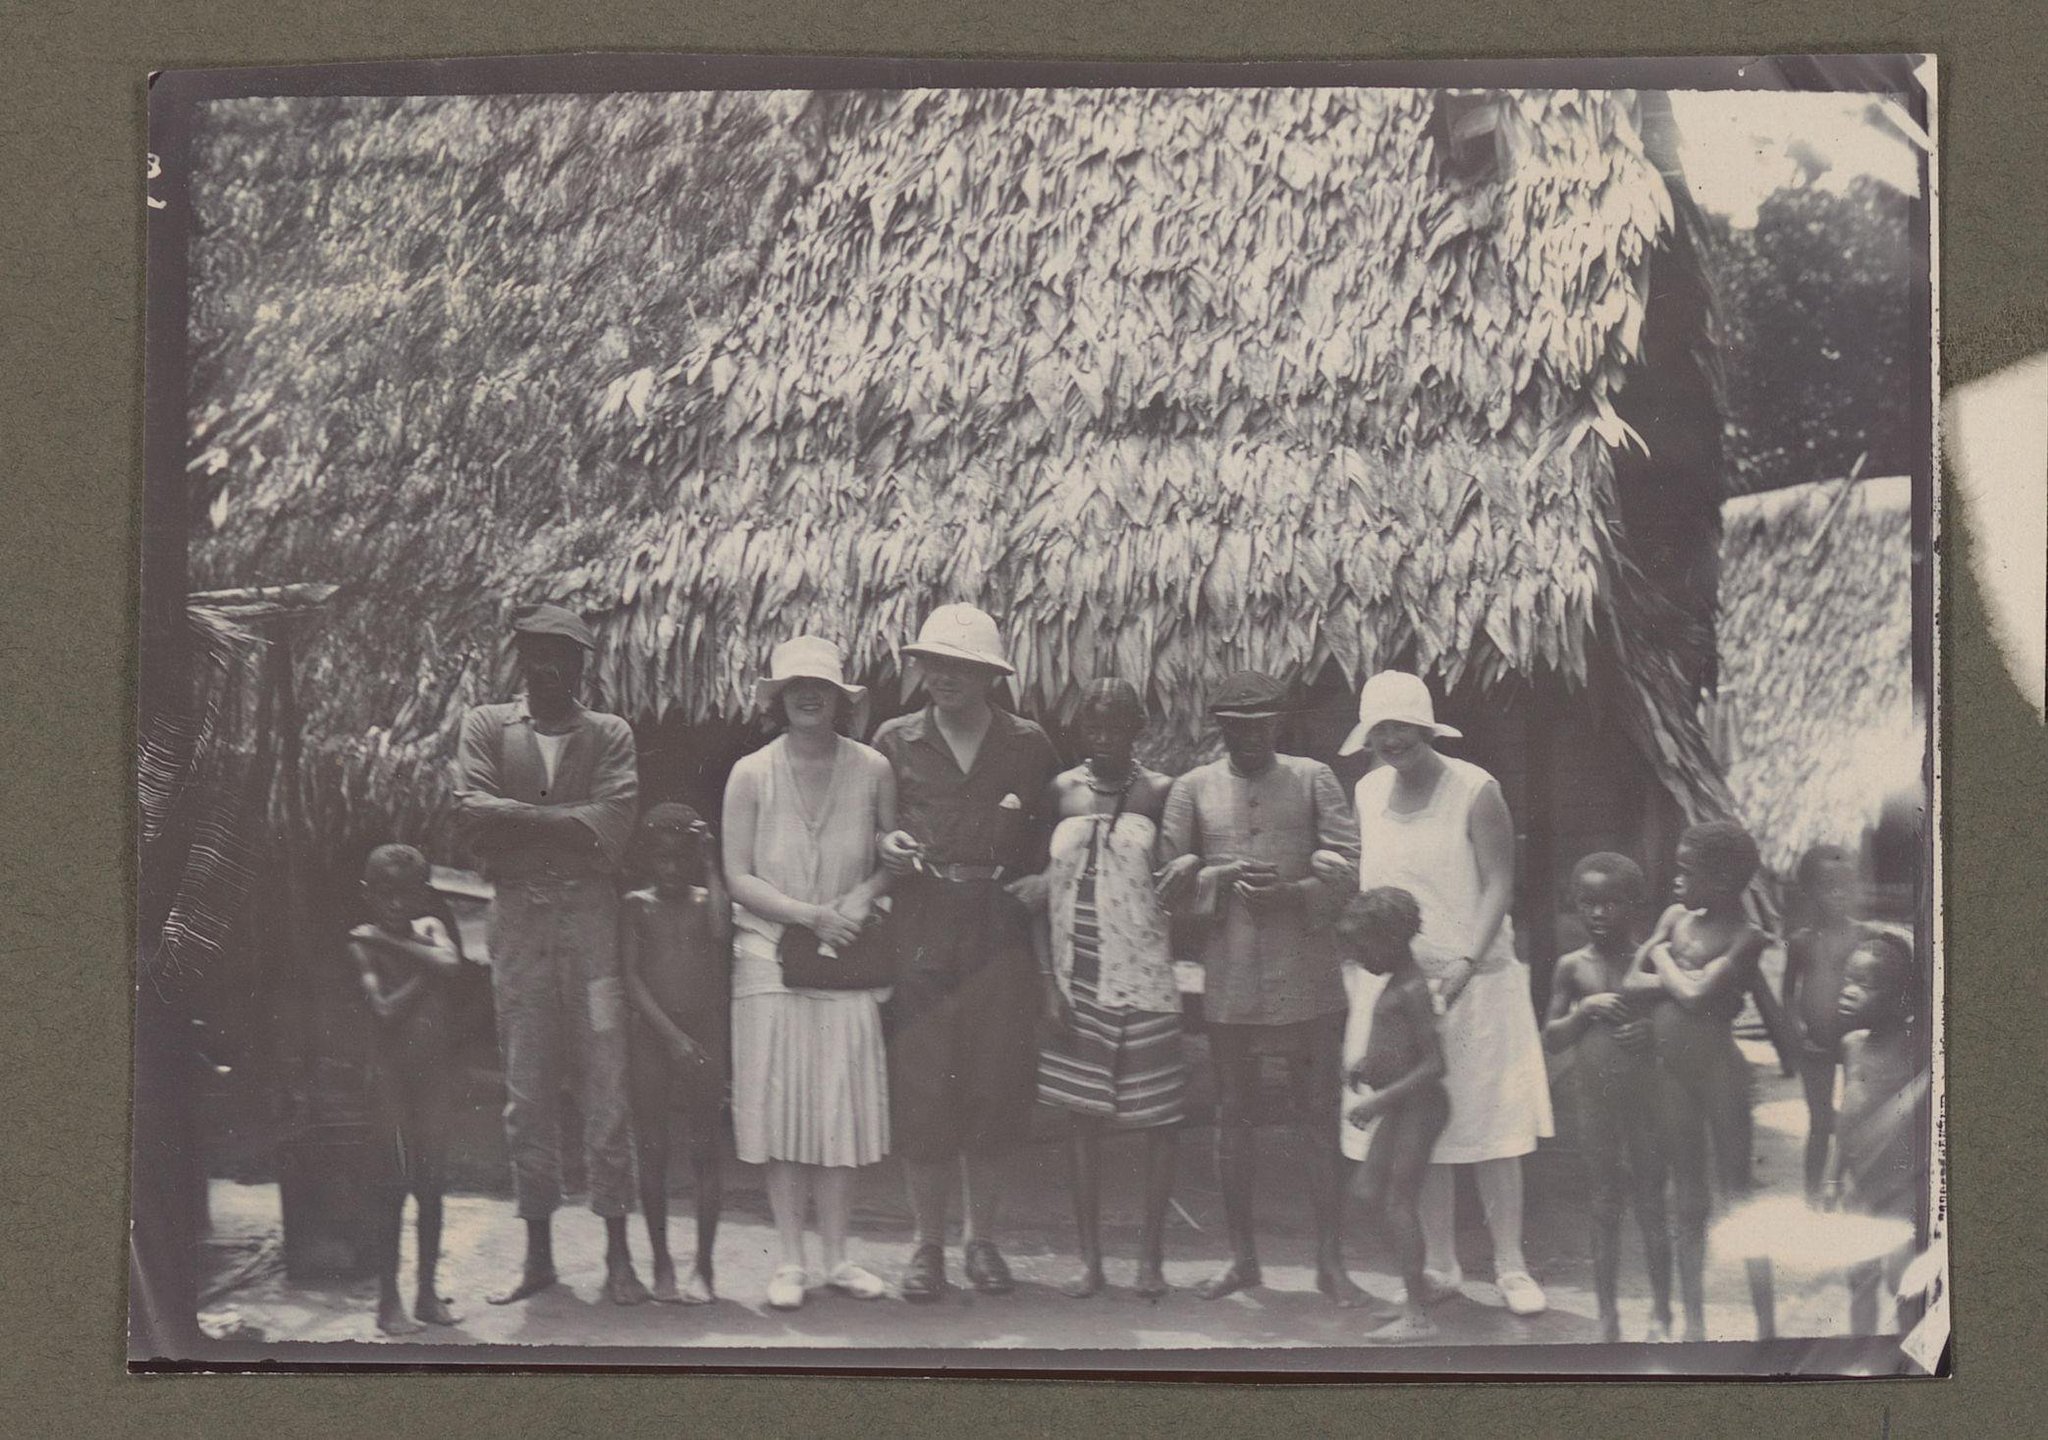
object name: photograph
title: Bezoek aan een inlands dorp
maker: Anonymous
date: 1925-1927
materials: photographic support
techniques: photography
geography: suriname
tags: jetten, familie, moengo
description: Bezoek aan een inlands dorp door een groep Nederlanders waaronder het echtpaar Jetten. Foto op een bladzijde van een los albumblad waarvan een hoek met twee foto's is uitgescheurd. Onderdeel van het ensemble met foto's van de familie van ingenieur Jetten in de mijnbouwstad Moengo in Suriname.